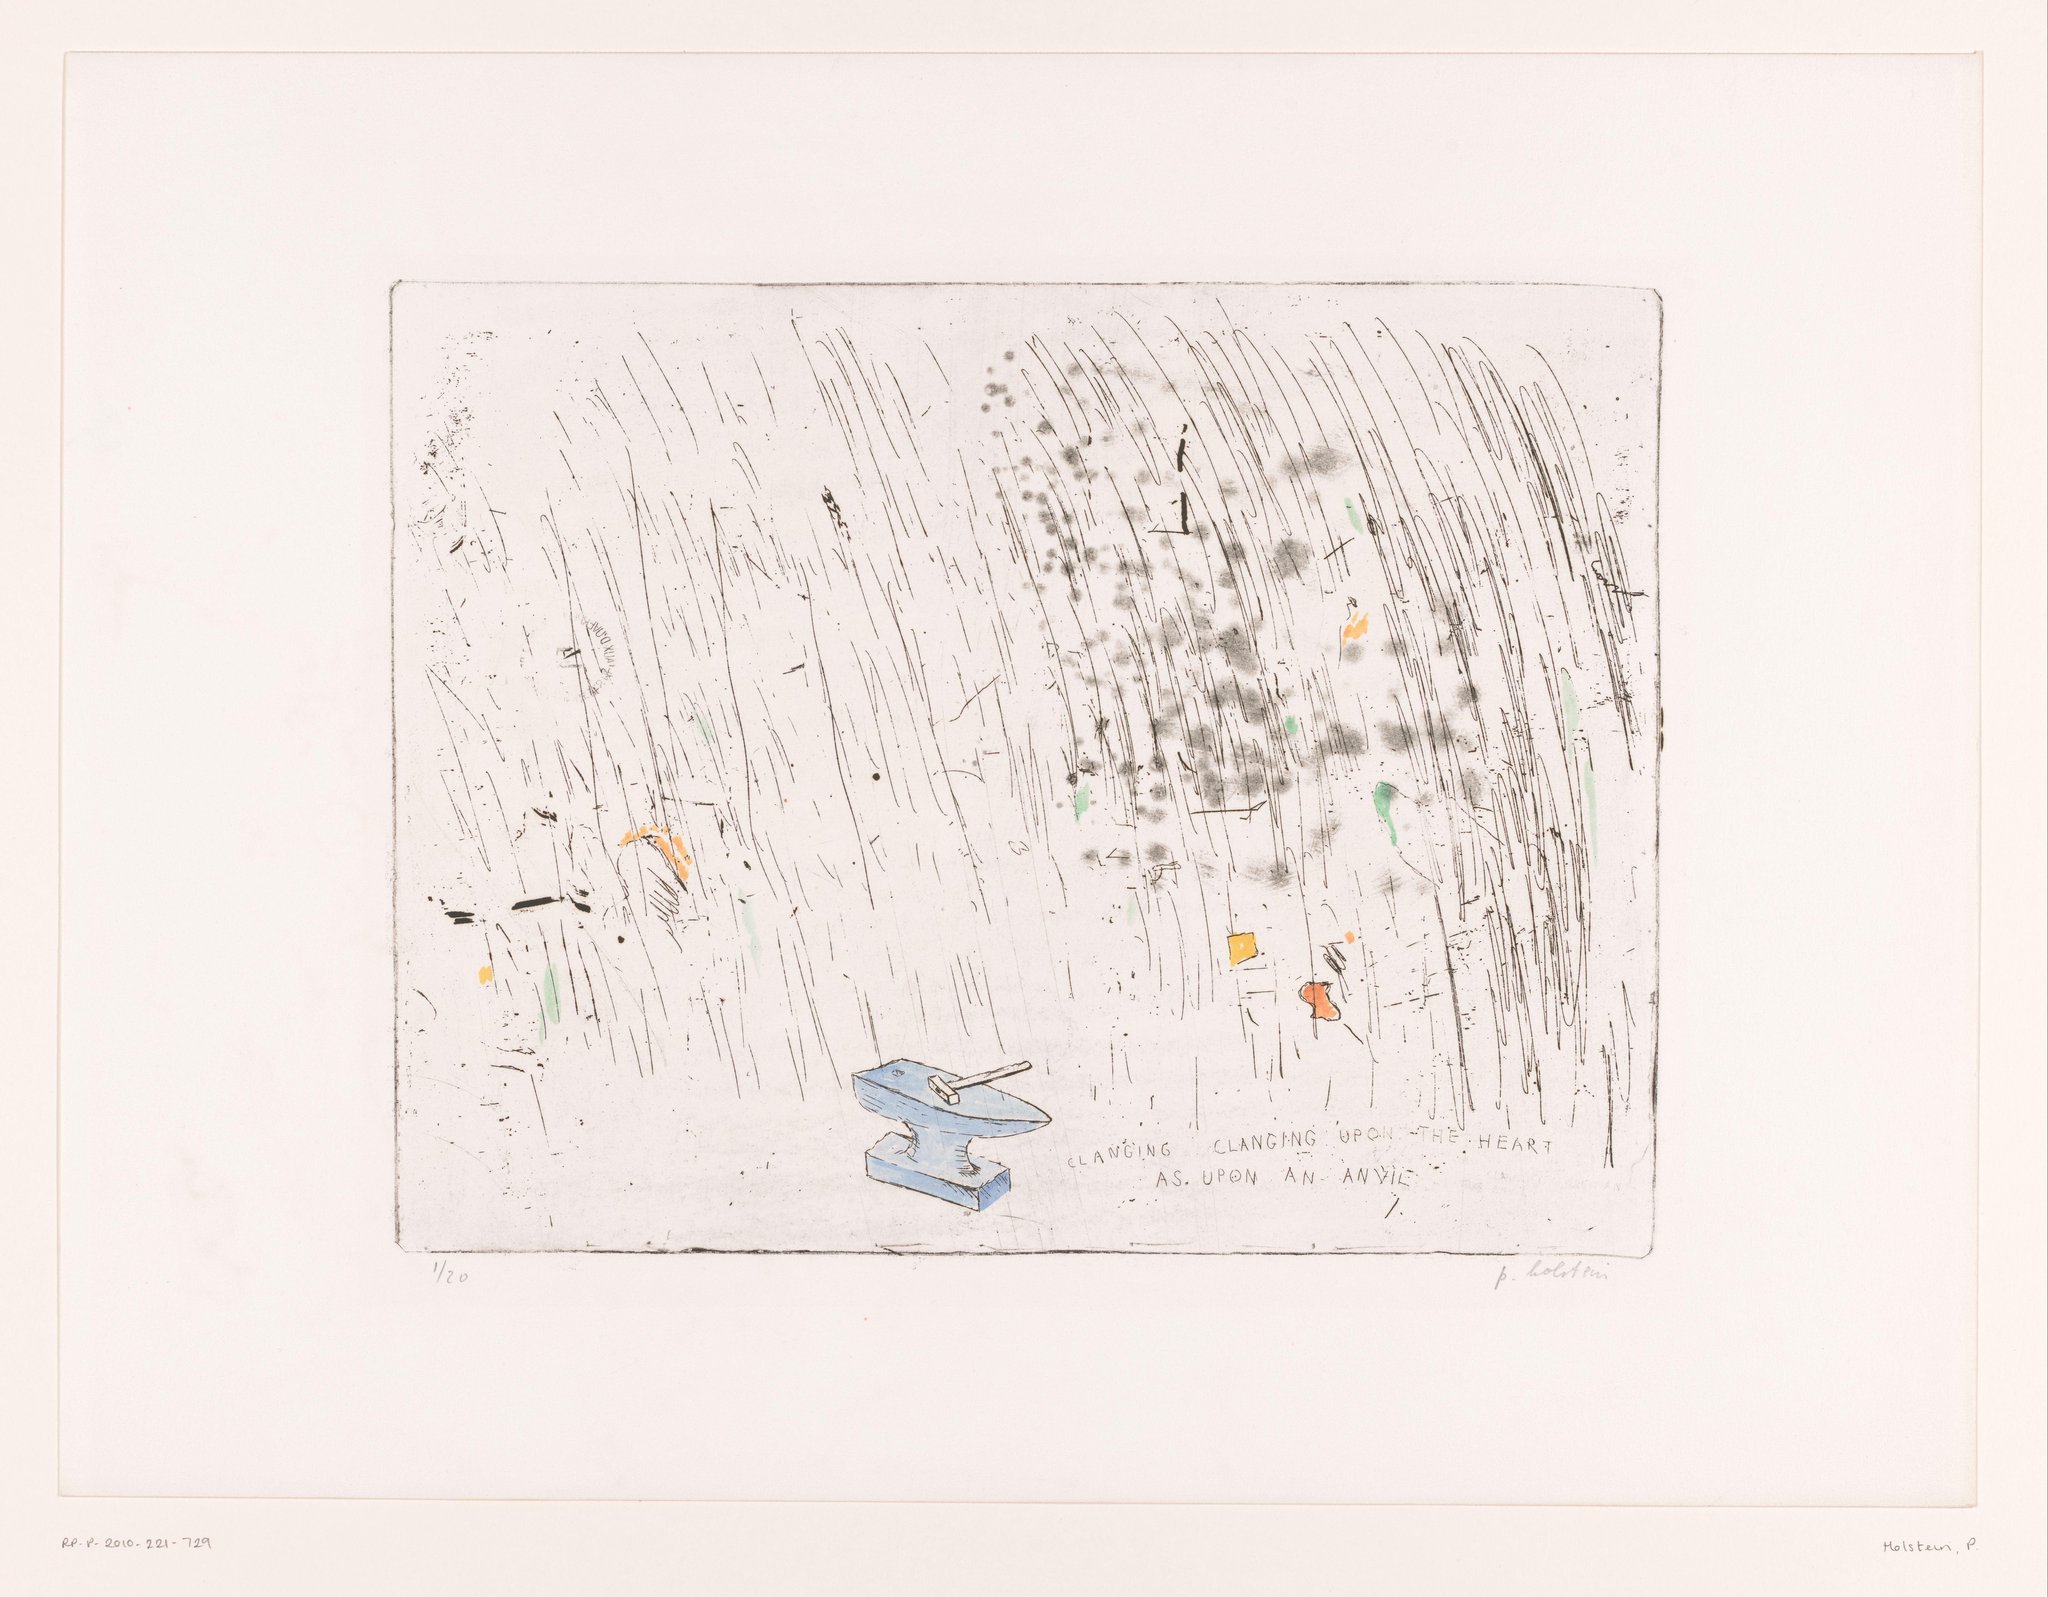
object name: print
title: Staying in the heart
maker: pieter holstein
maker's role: draughtsman, painter, print maker, sculptor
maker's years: 1934-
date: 1968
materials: paper, watercolor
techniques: brush, etching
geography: amsterdam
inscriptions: signature: ‘p. holstein’, title: ‘CLANGING CLANGING UPON THE HEART / AS UPON AN ANVIL’, edition: ‘1/20’